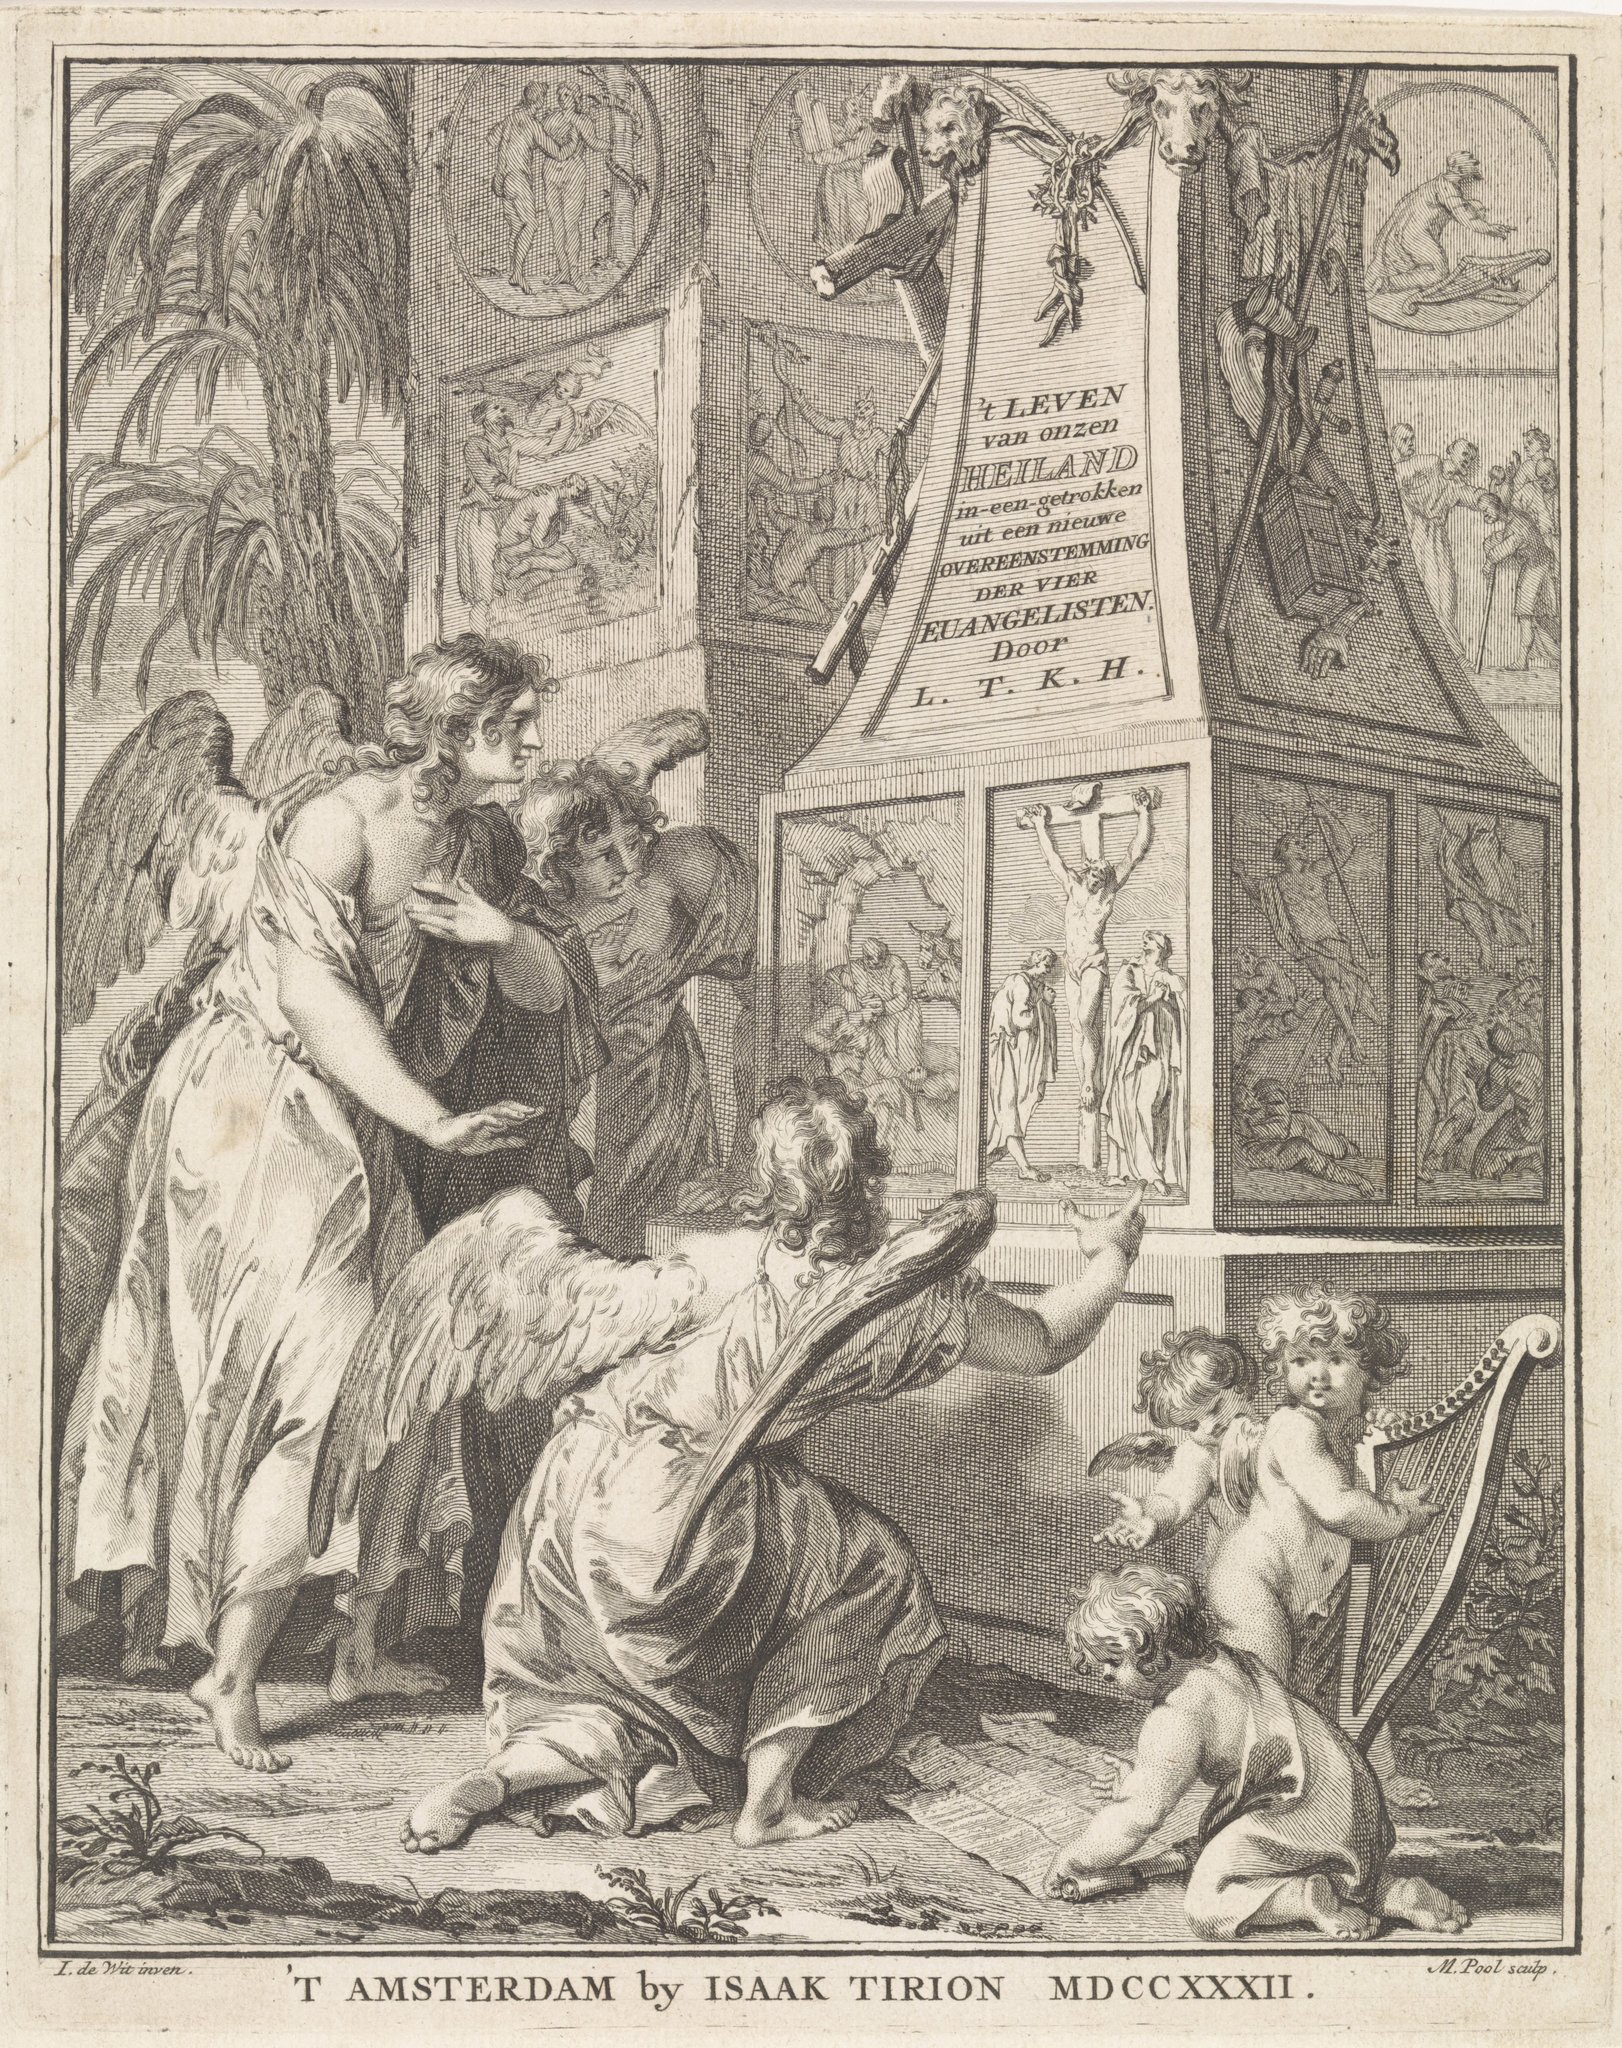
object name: print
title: Drie engelen bewonderen een obelisk met scènes uit het Nieuwe Testament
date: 1732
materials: paper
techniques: engraving, etching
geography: amsterdam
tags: obelisks (garden ornaments), single instruments of the passion, resurrection of christ, harp, crucified christ with other persons, christ taken up by a cloud ~ ascension, old testament, angels, mary, joseph and the new-born christ (nativity)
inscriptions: collector's mark: Lugt 2228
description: Landschap met drie engelen bij een obelisk. Op het monument de titel in het Nederlands, te midden van passiewerktuigen en andere attributen die verwijzen naar het leven van Christus. Op het basement scènes uit het Nieuwe Testament, respectievelijk de geboorte van Christus, de kruisiging, de opstanding en de hemelvaart. Op de achtergrond een zuil met scènes uit het Oude Testament. Op de voorgrond drie putti. Eén van hen bespeelt een harp, een ander rolt papier uit op de grond.